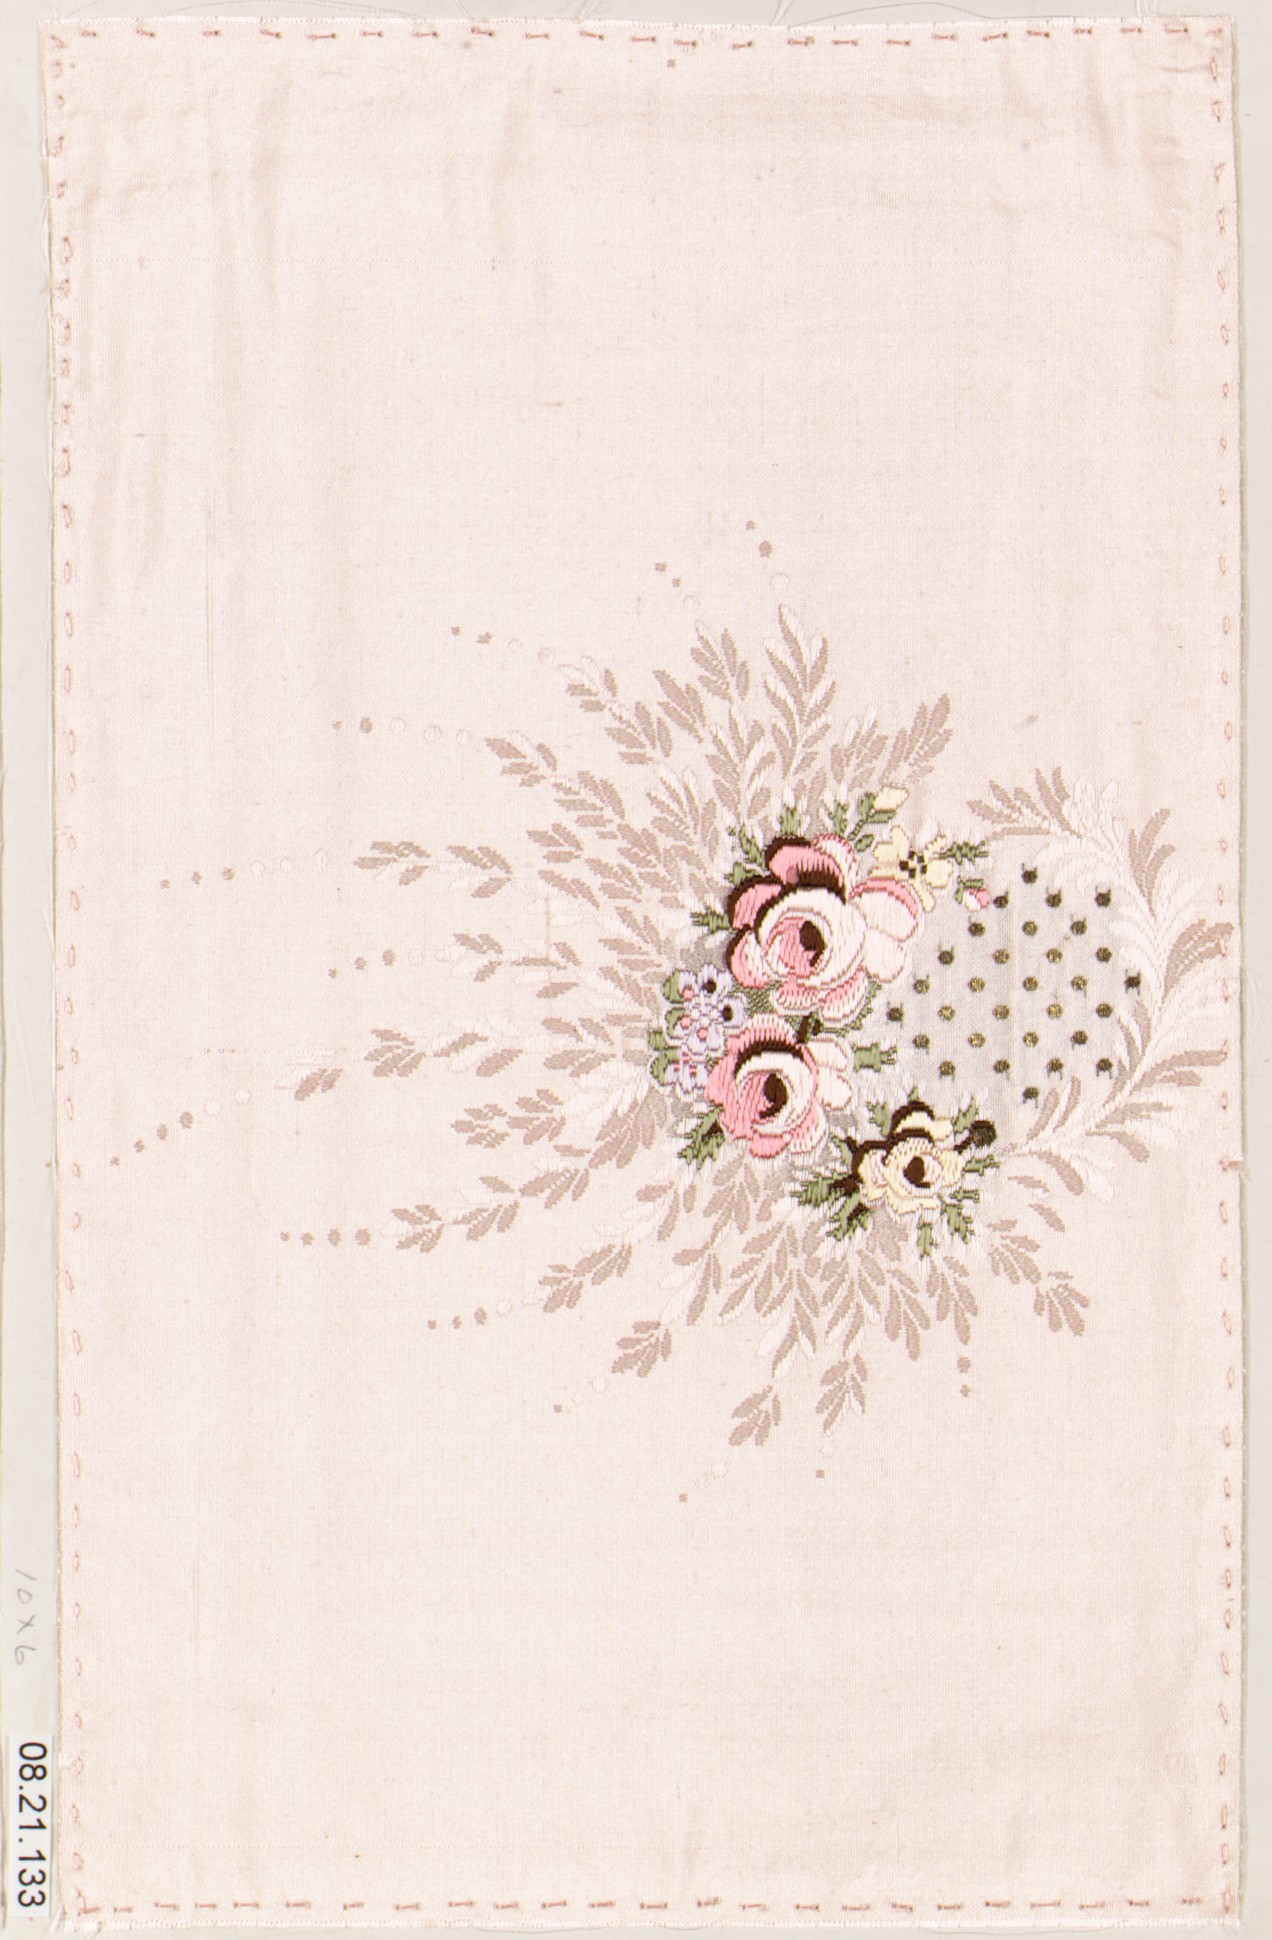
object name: textile sample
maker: Anonymous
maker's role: designer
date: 1900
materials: silk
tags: flowers